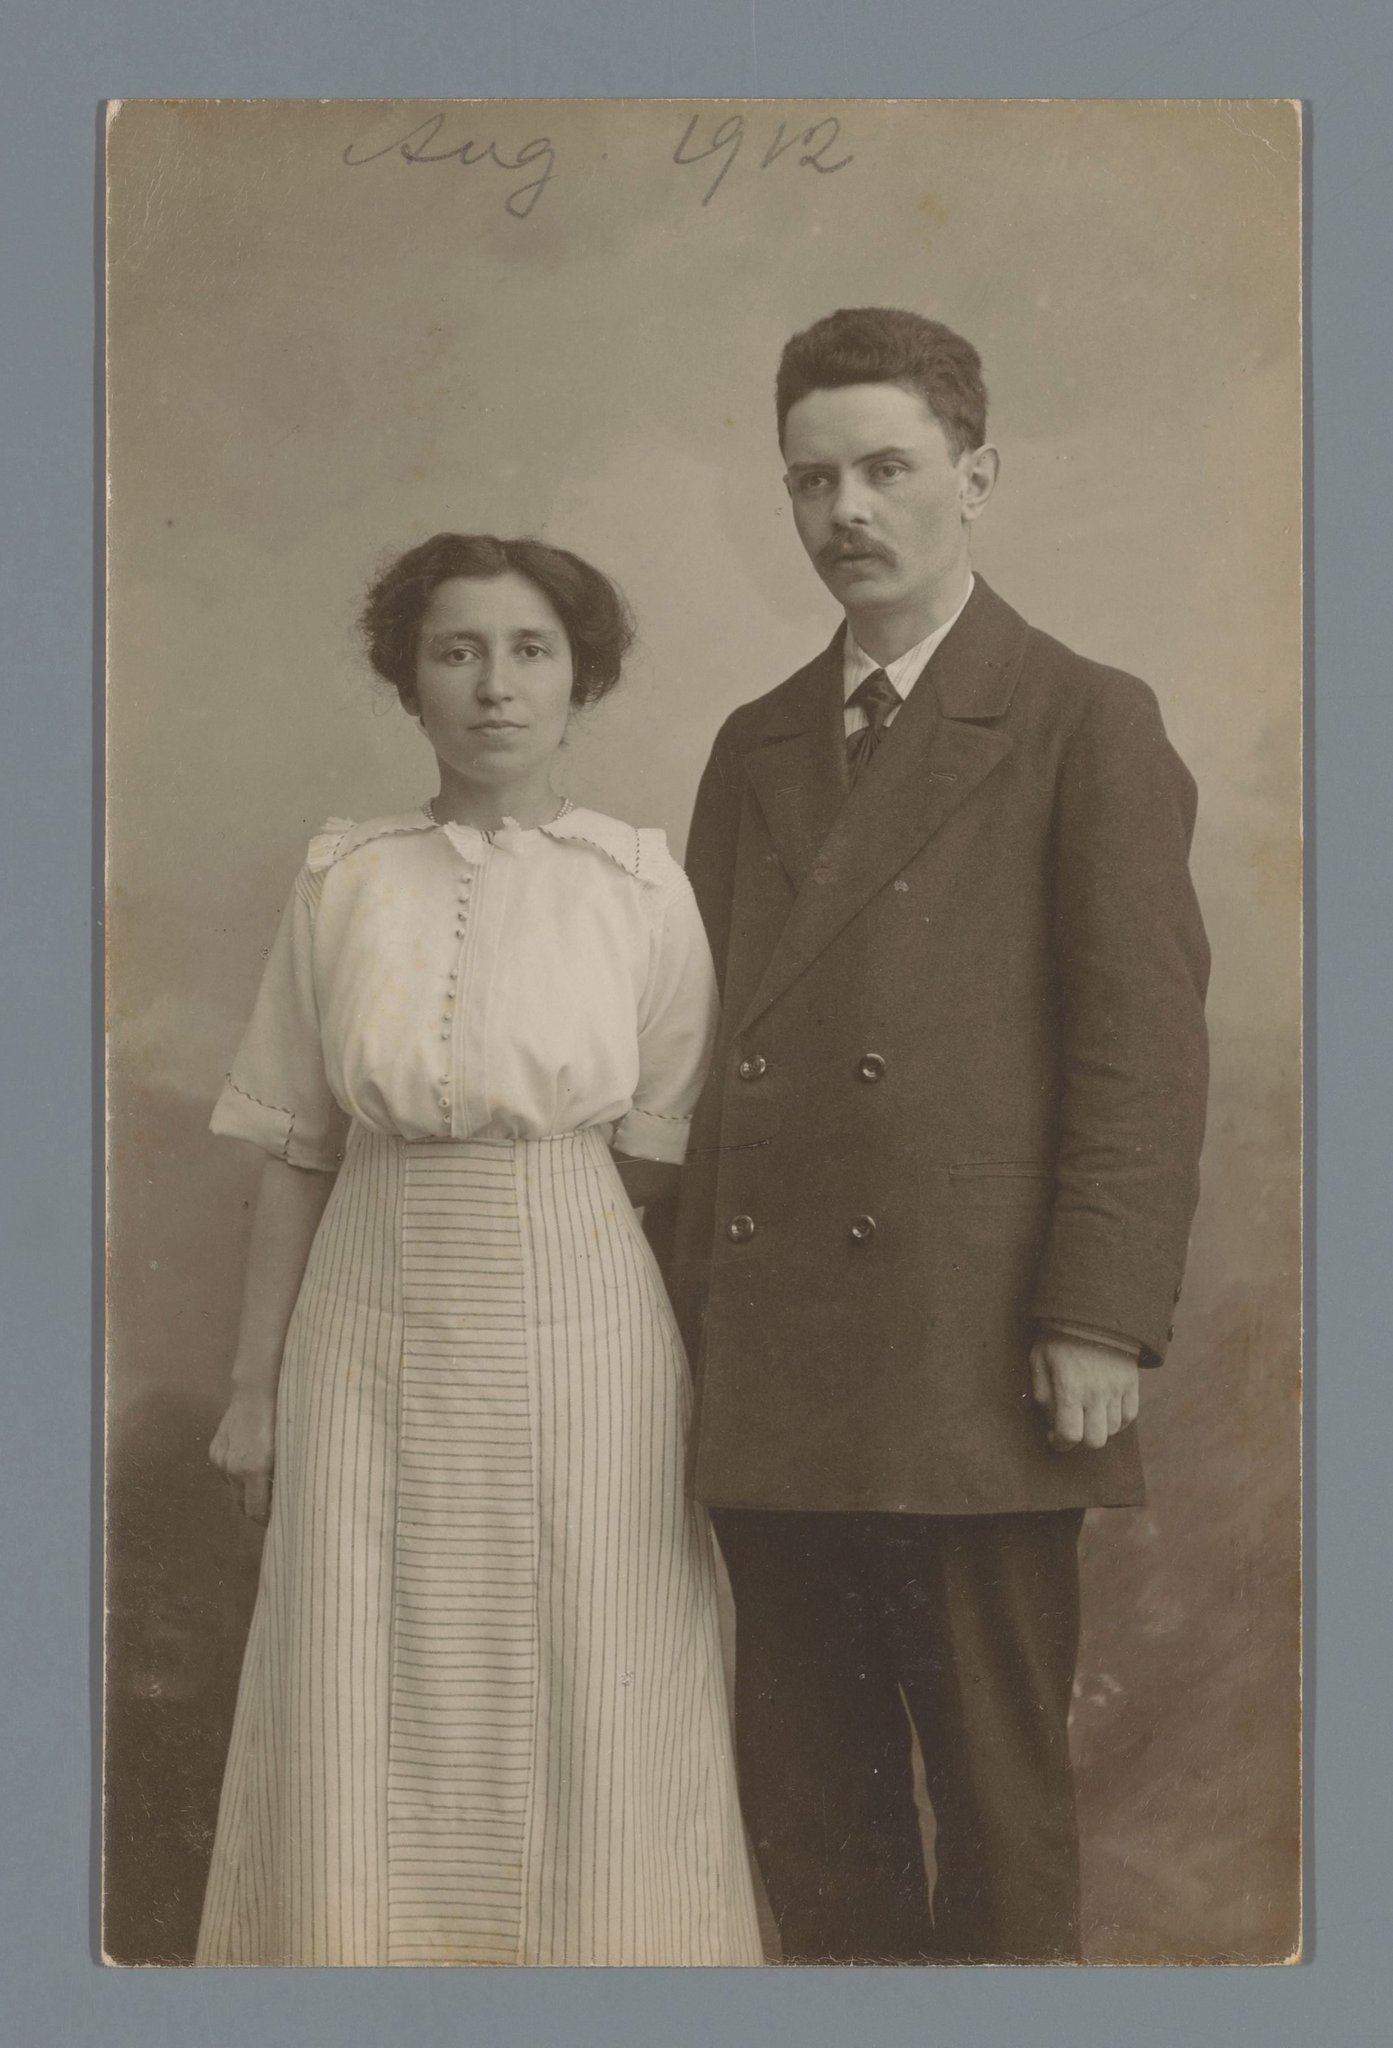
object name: photograph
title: Studioportret van een onbekende man en vrouw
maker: Anonymous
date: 1908-1912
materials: photographic support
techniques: gelatin silver print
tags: marriage, married couple, 'matrimonium'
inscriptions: inscription: ‘Aug 1912’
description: Dezelfde man is geportretteerd op RP-F-F20788 en RP-F-F20789.